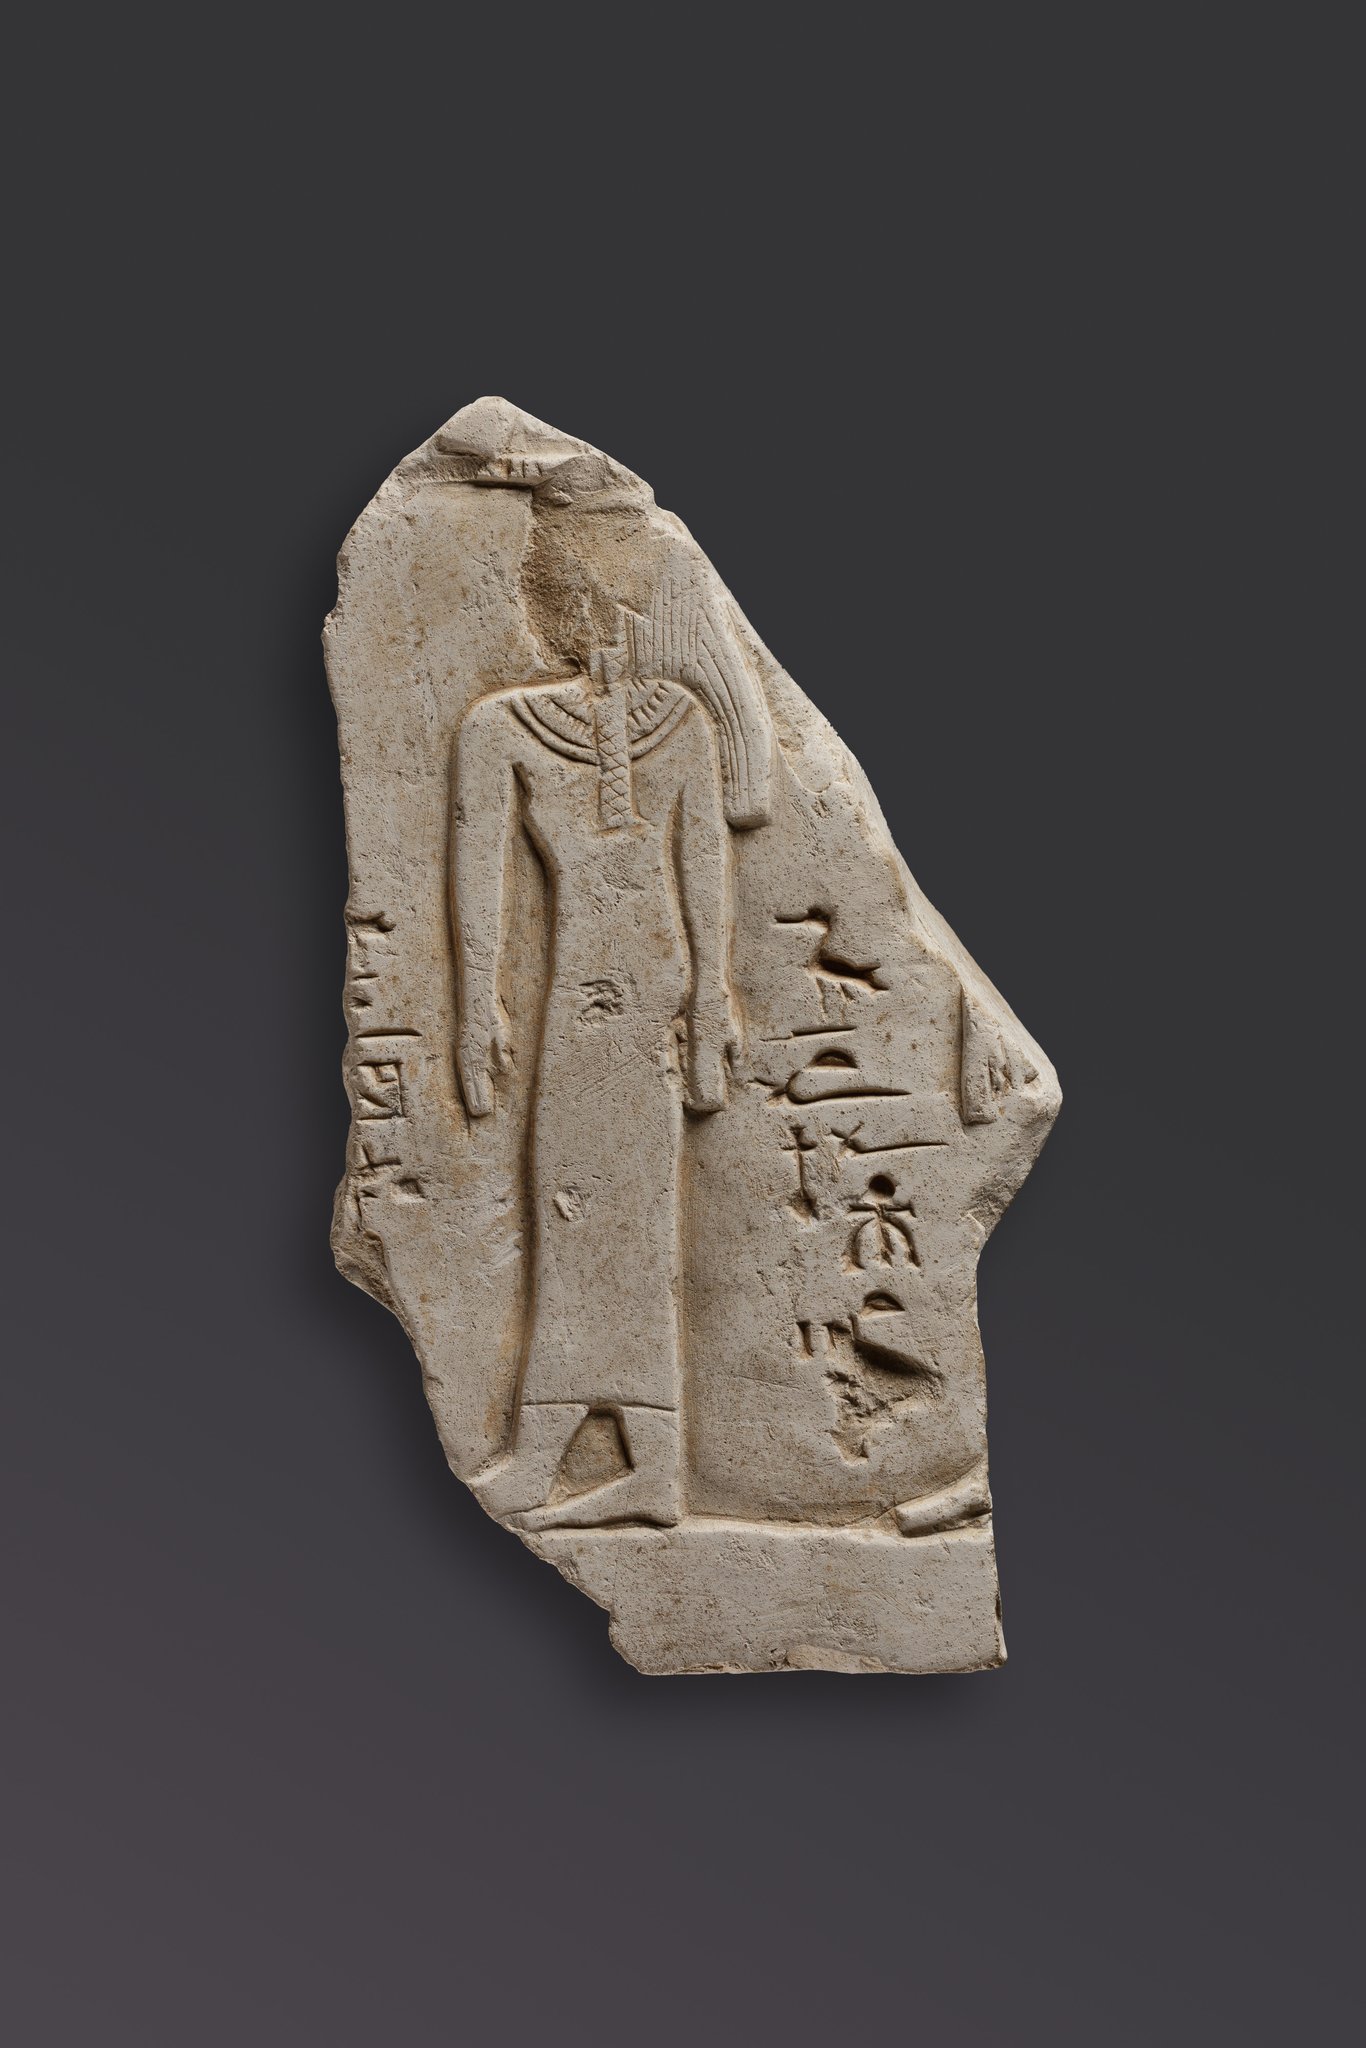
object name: relief fragment, tomb of mereri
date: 2100-2090 BCE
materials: limestone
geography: egypt